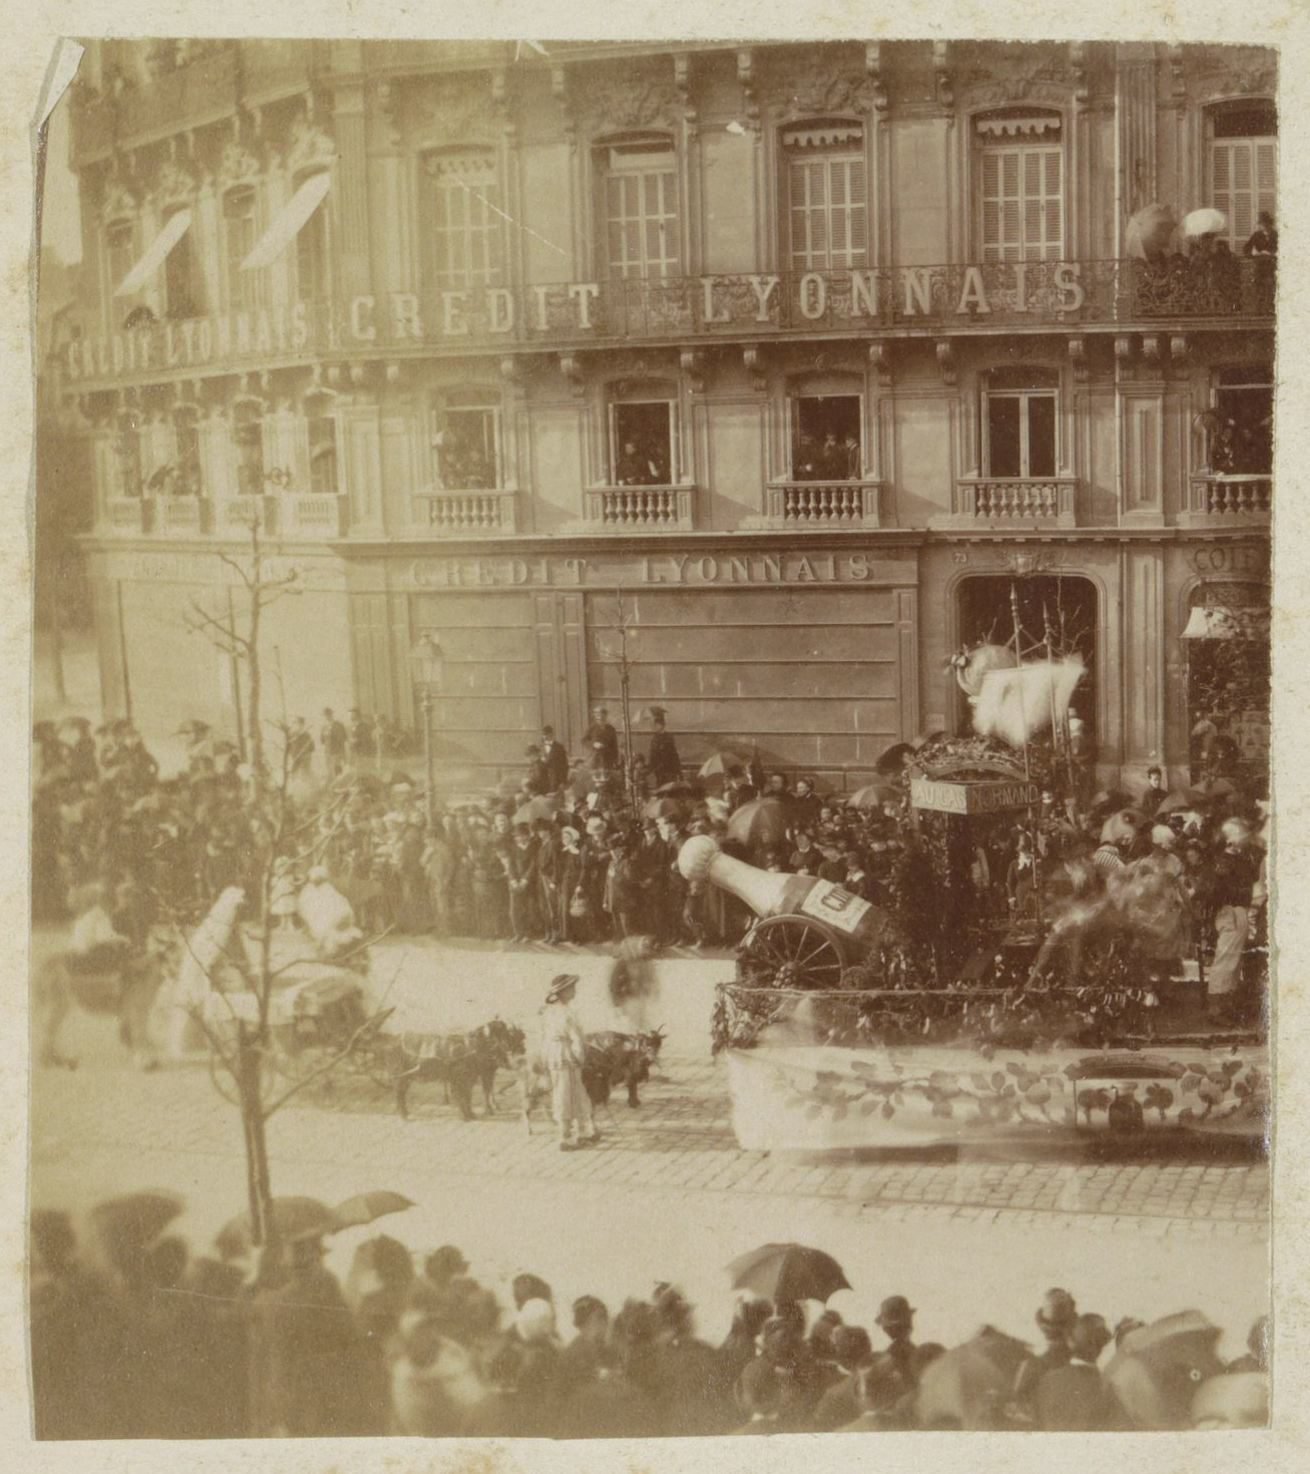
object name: photograph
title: Optocht in Le Havre ter gelegenheid van Paasmaandag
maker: Anonymous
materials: photographic support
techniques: albumen print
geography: le havre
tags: easter (non-liturgical celebration) (+ parade, pageant, cavalcade ~ festive activities), le havre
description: Onderdeel van Album van een Franse amateurfotograaf met opnames van familie, militairen, industrie, landschappen en bezienswaardigheden in Frankrijk.